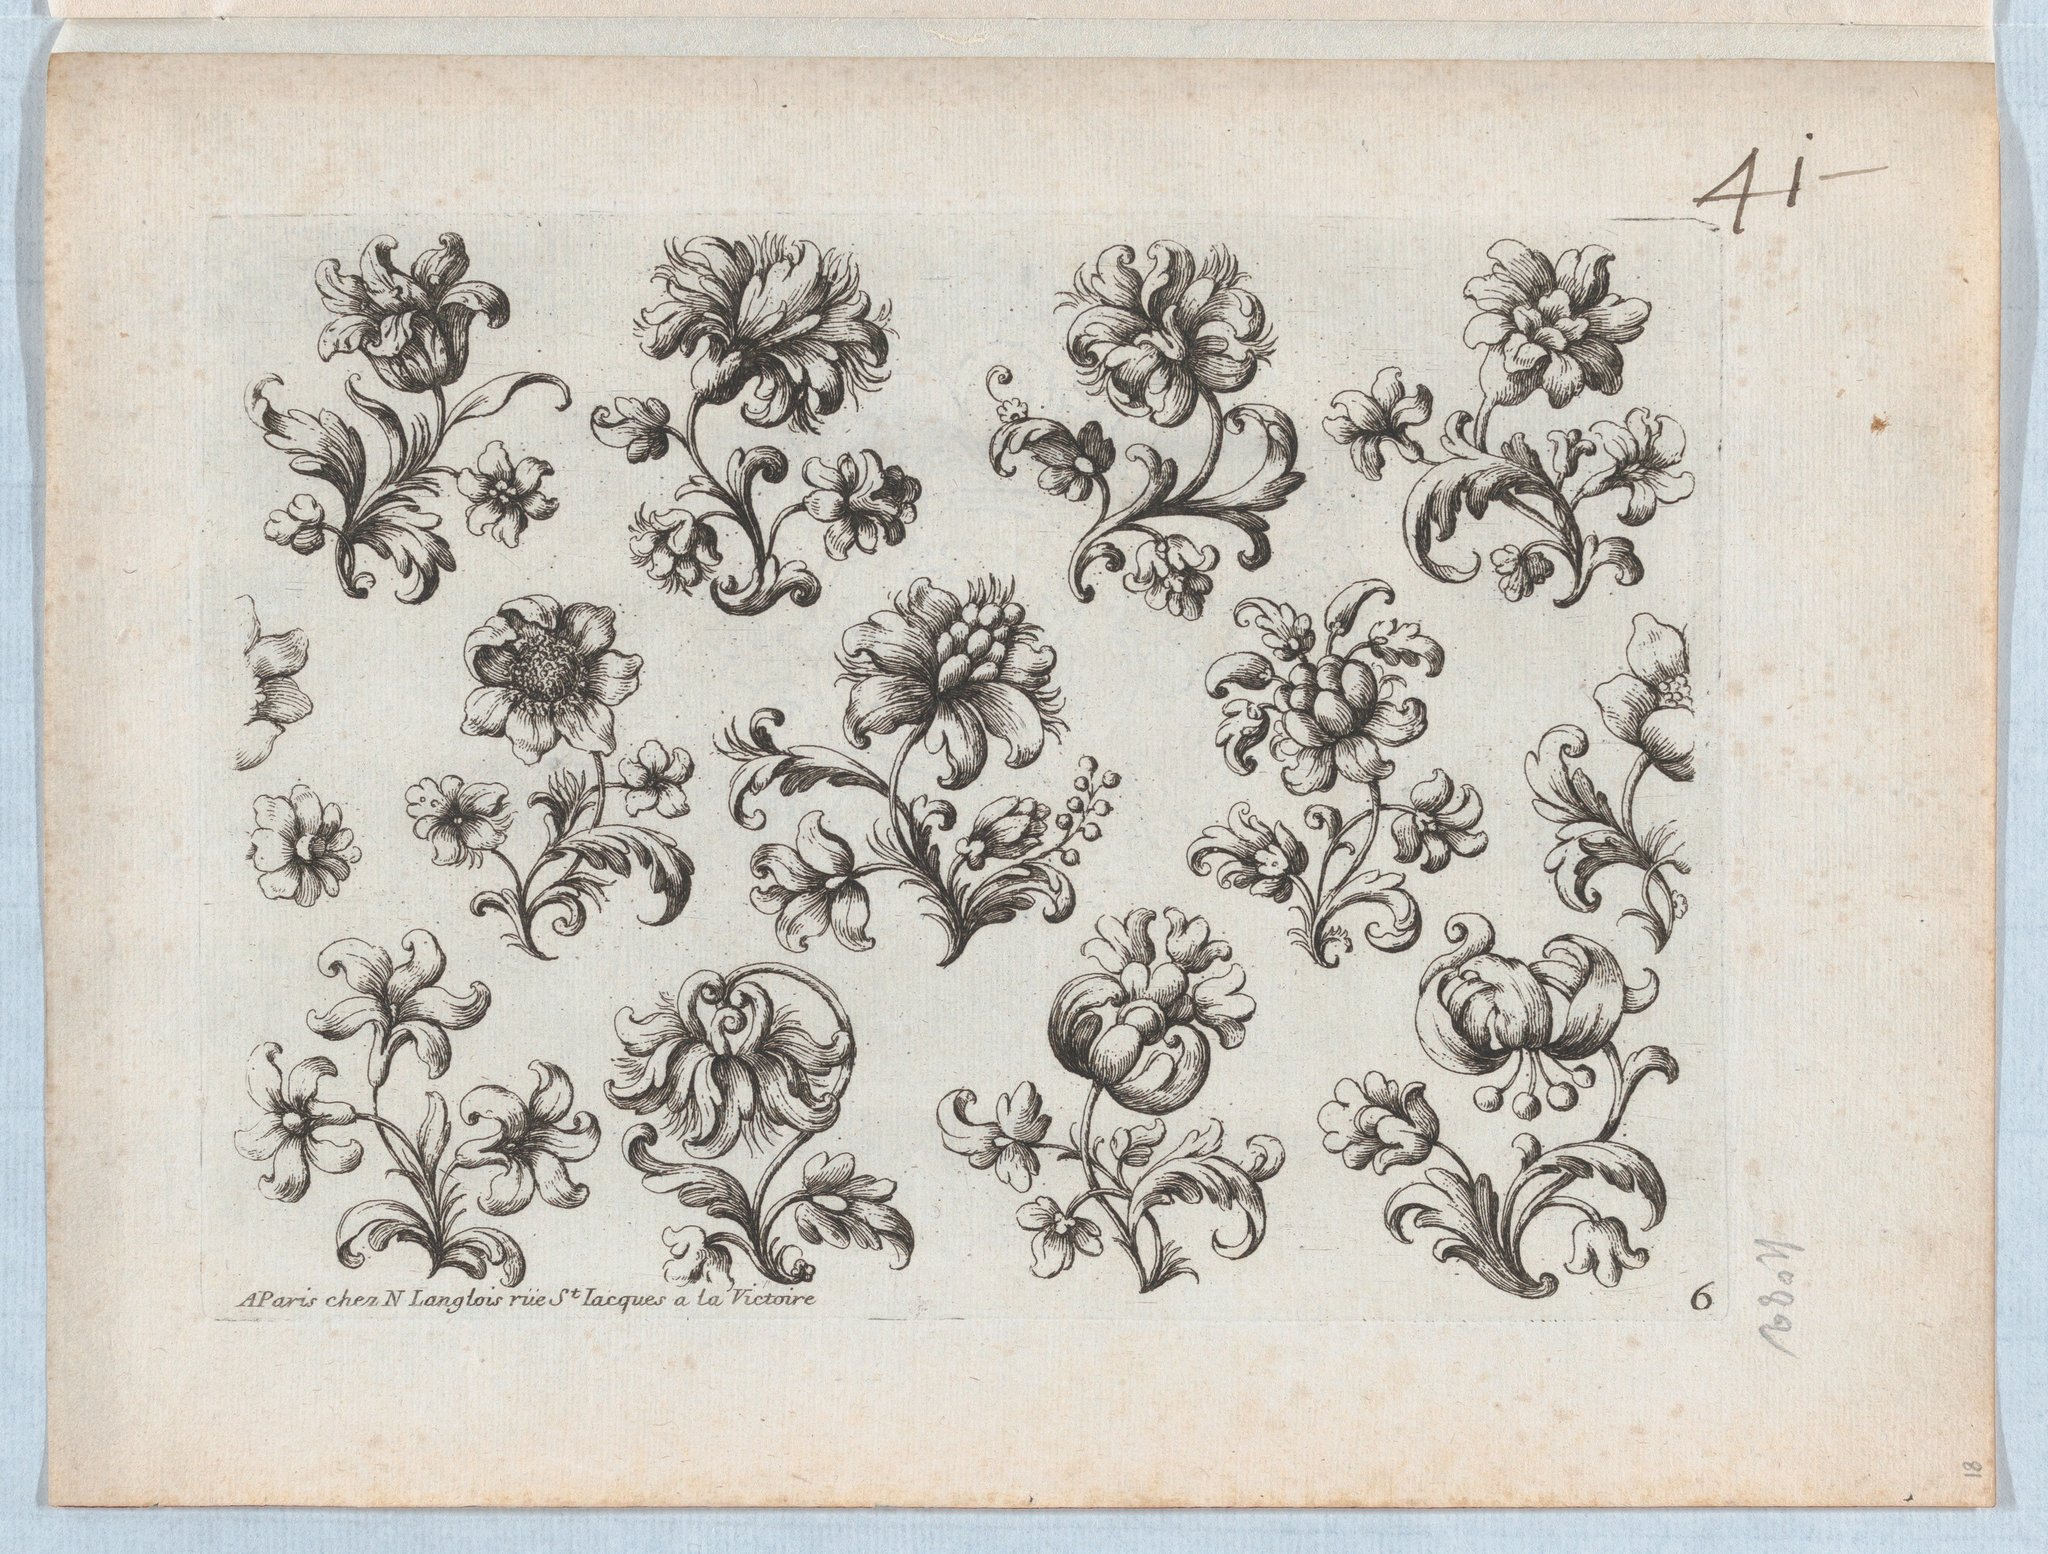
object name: print ornament architecture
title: Series of Small Flower Motifs, Plate 6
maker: paul androuet ducerceau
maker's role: artist and engraver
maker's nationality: french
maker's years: 1623-1710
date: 1670-1685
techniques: etching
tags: flowers